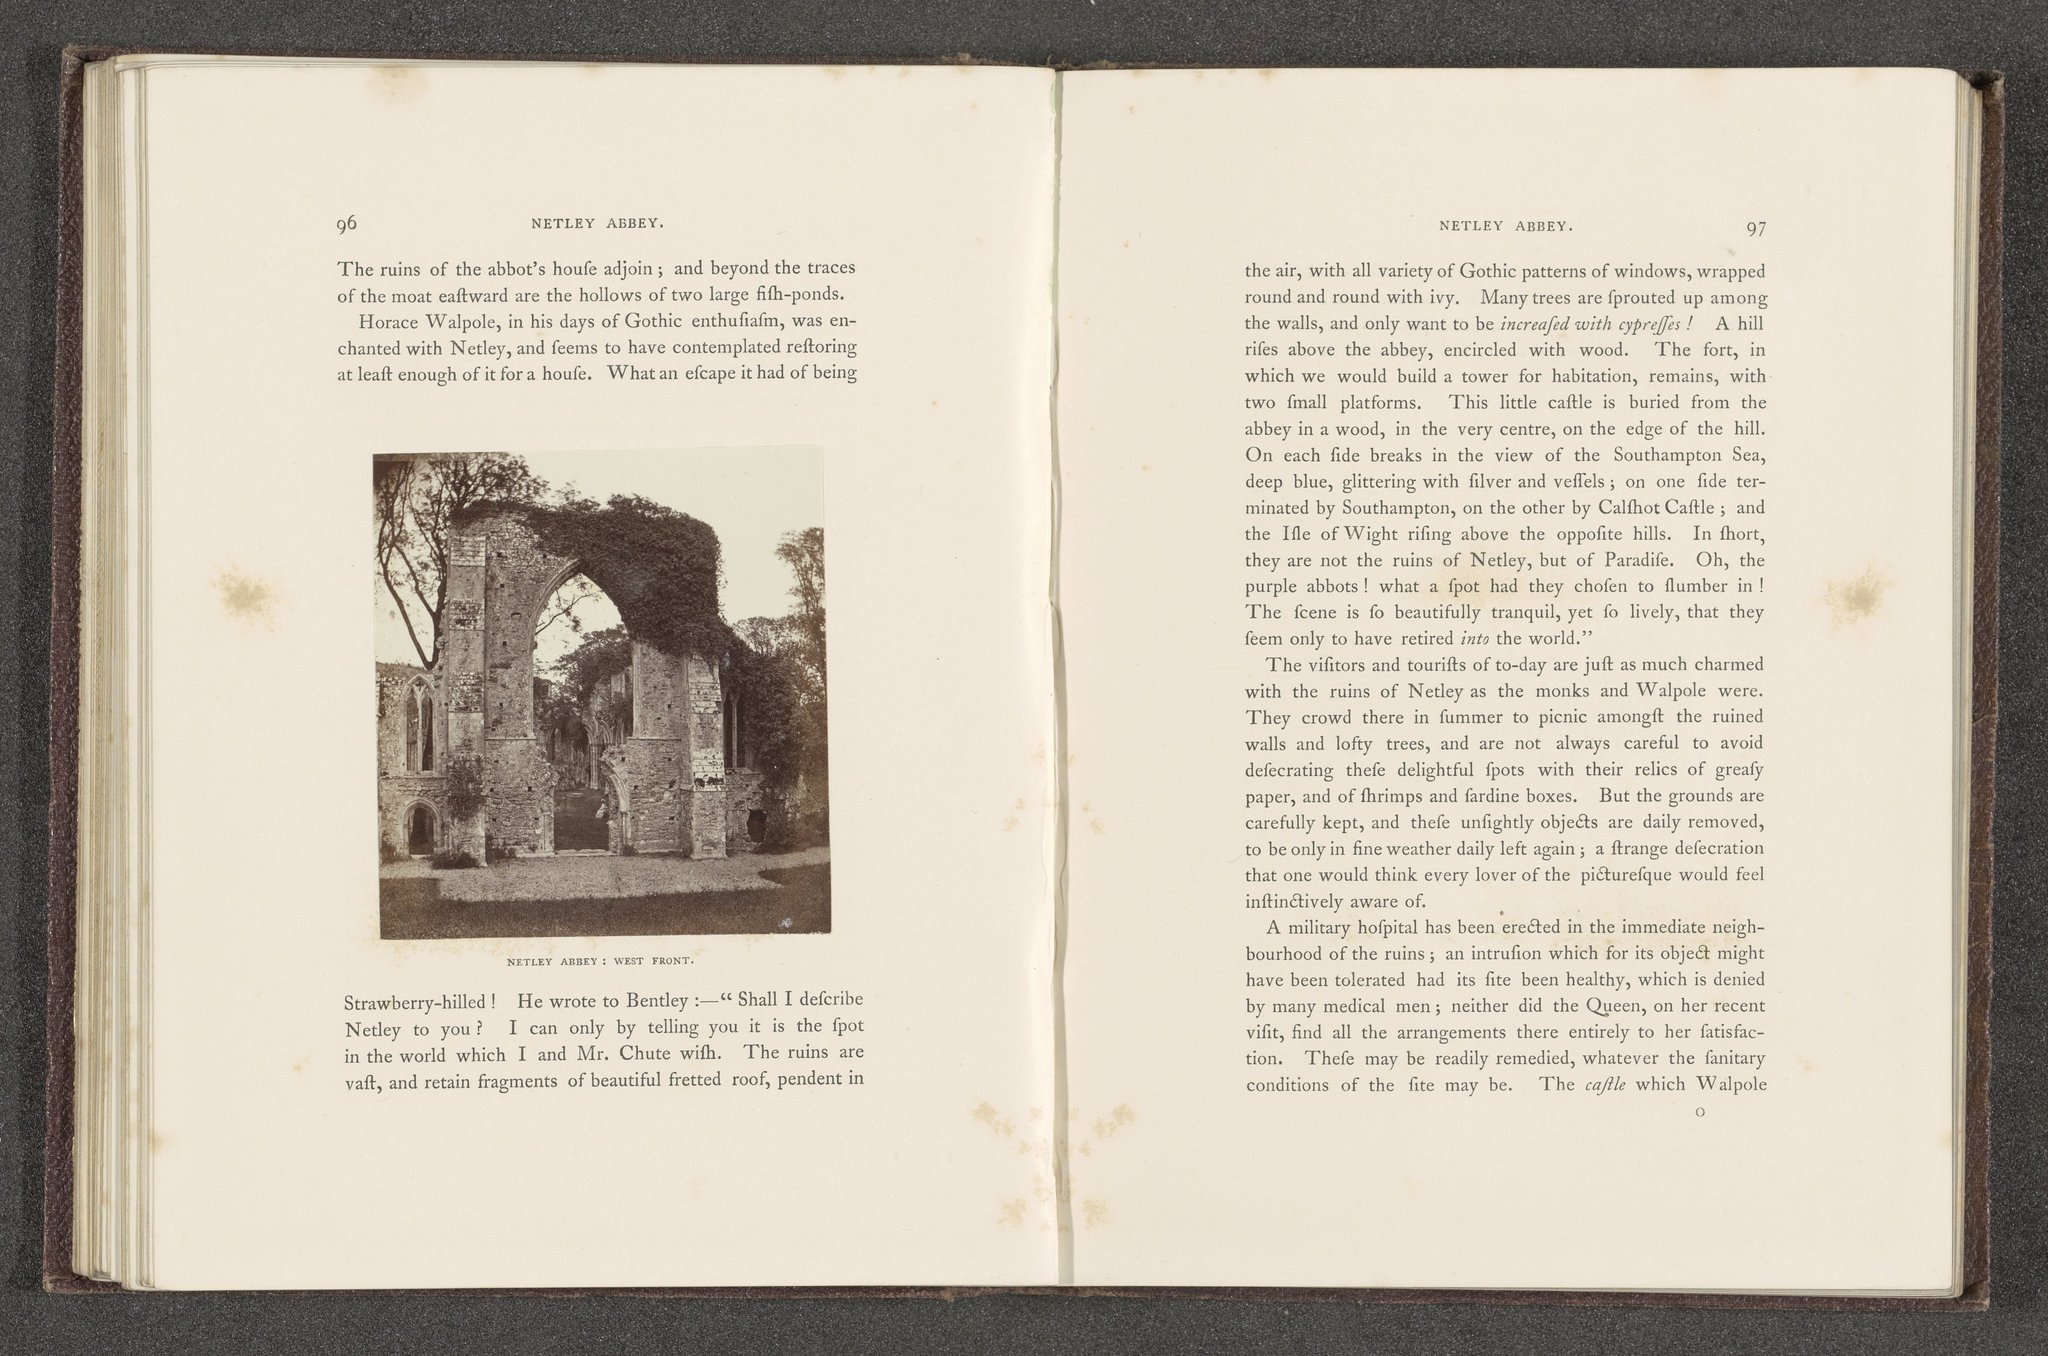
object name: photograph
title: Netley Abbey : West Front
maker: stephen thompson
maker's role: fotograaf, schrijver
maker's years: 1831-1893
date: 1854-1864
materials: photographic support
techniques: albumen print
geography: netley abbey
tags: ruin of church, monastery, etc.